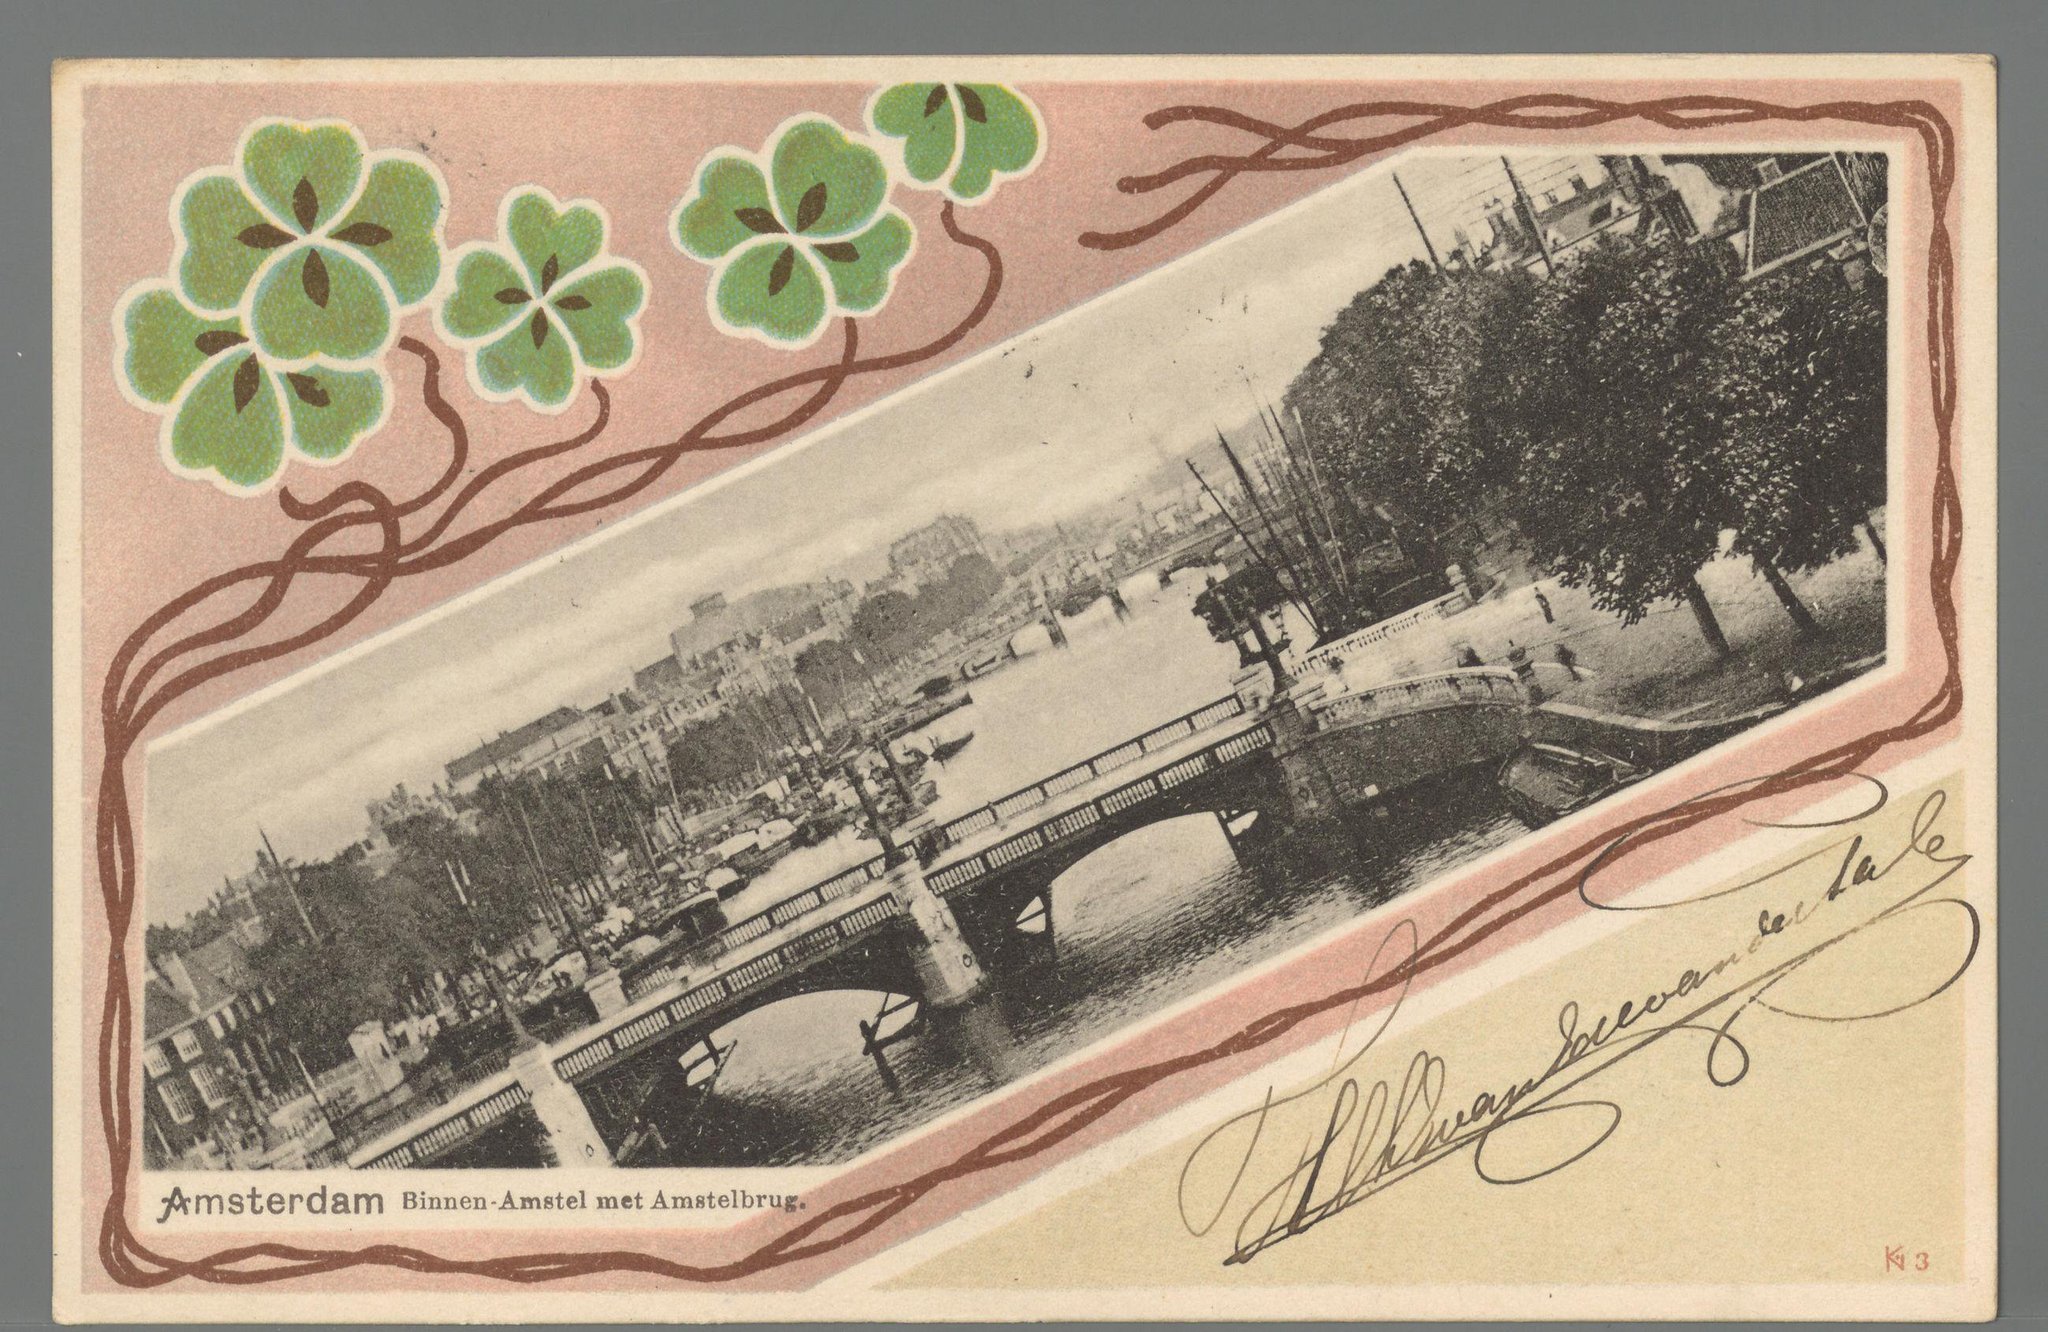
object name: photomechanical print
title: Amsterdam Binnen-Amstel met Amstelbrug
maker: Anonymous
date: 1900-1905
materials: cardboard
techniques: photograph, lithograph, writing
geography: amsterdam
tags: bridge in city across river, canal, etc., amsterdam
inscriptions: postage stamp